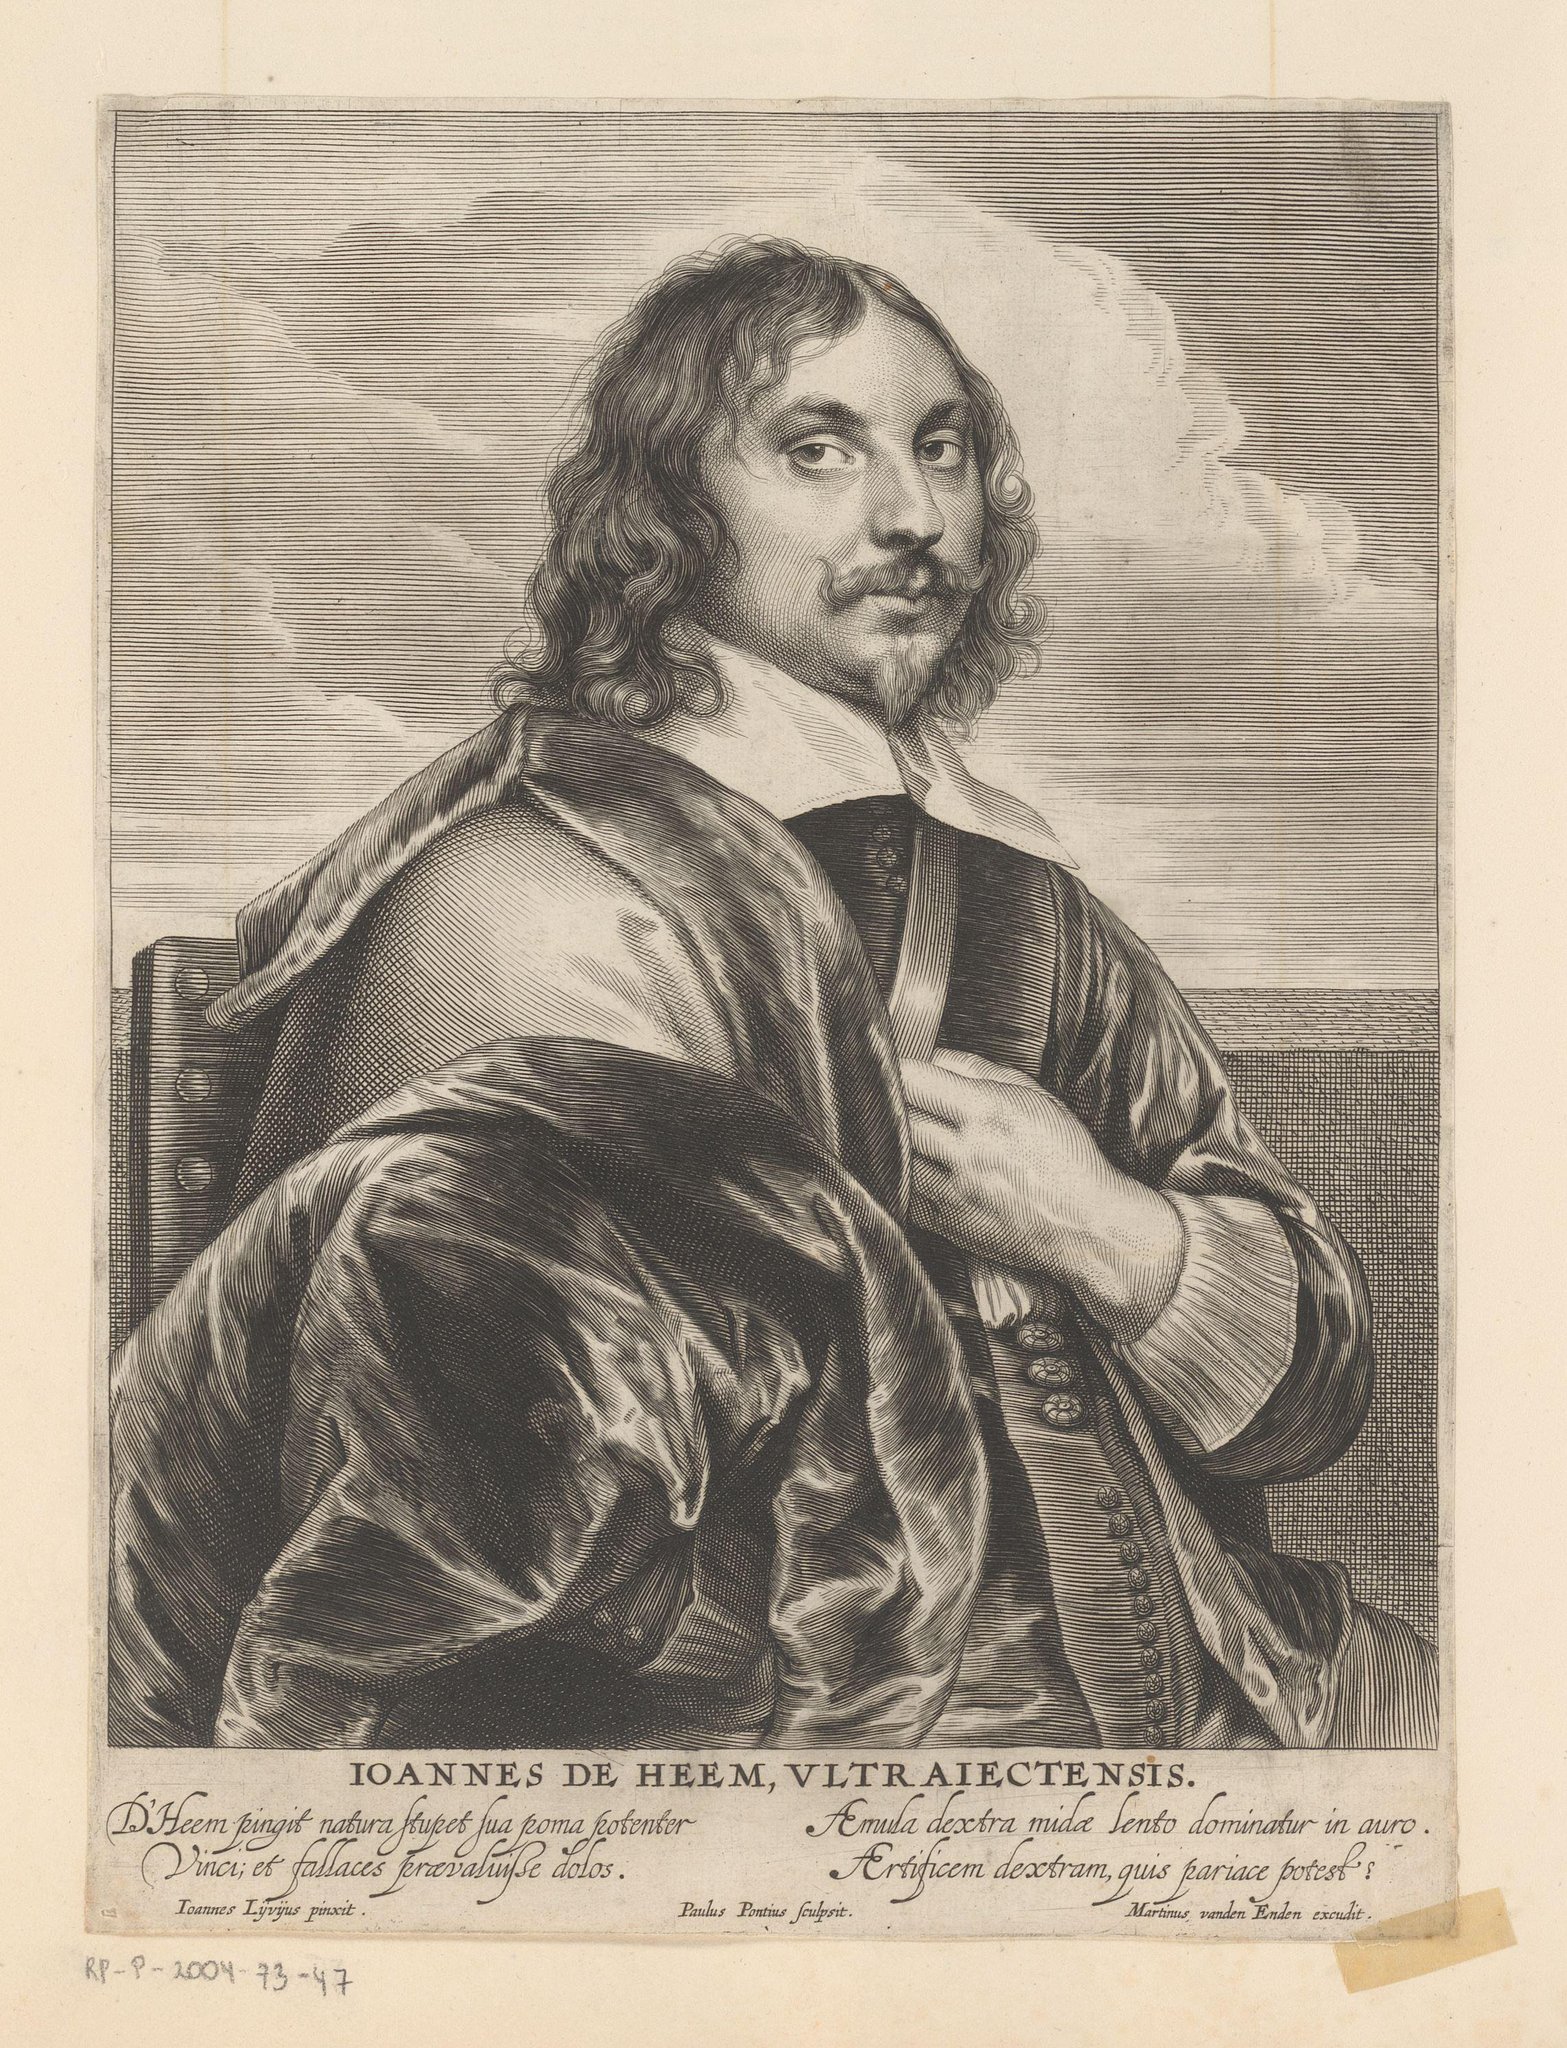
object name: album leaf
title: Portret van Jan Davidsz. de Heem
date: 1630-1658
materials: paper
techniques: engraving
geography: antwerp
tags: utrecht, antwerp, painter, jan davidsz. de heem, historical persons, portrait, self-portrait of painter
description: De samensteller heeft deze prent in het album geplakt als illustratie bij: Pilkington, Matthew en Johann Heinrich Füssli. A dictionary of painters, from the revival of the art to the present period. 4 dln. Londen: John Crowder, 1805, dl. 2, p. 237.